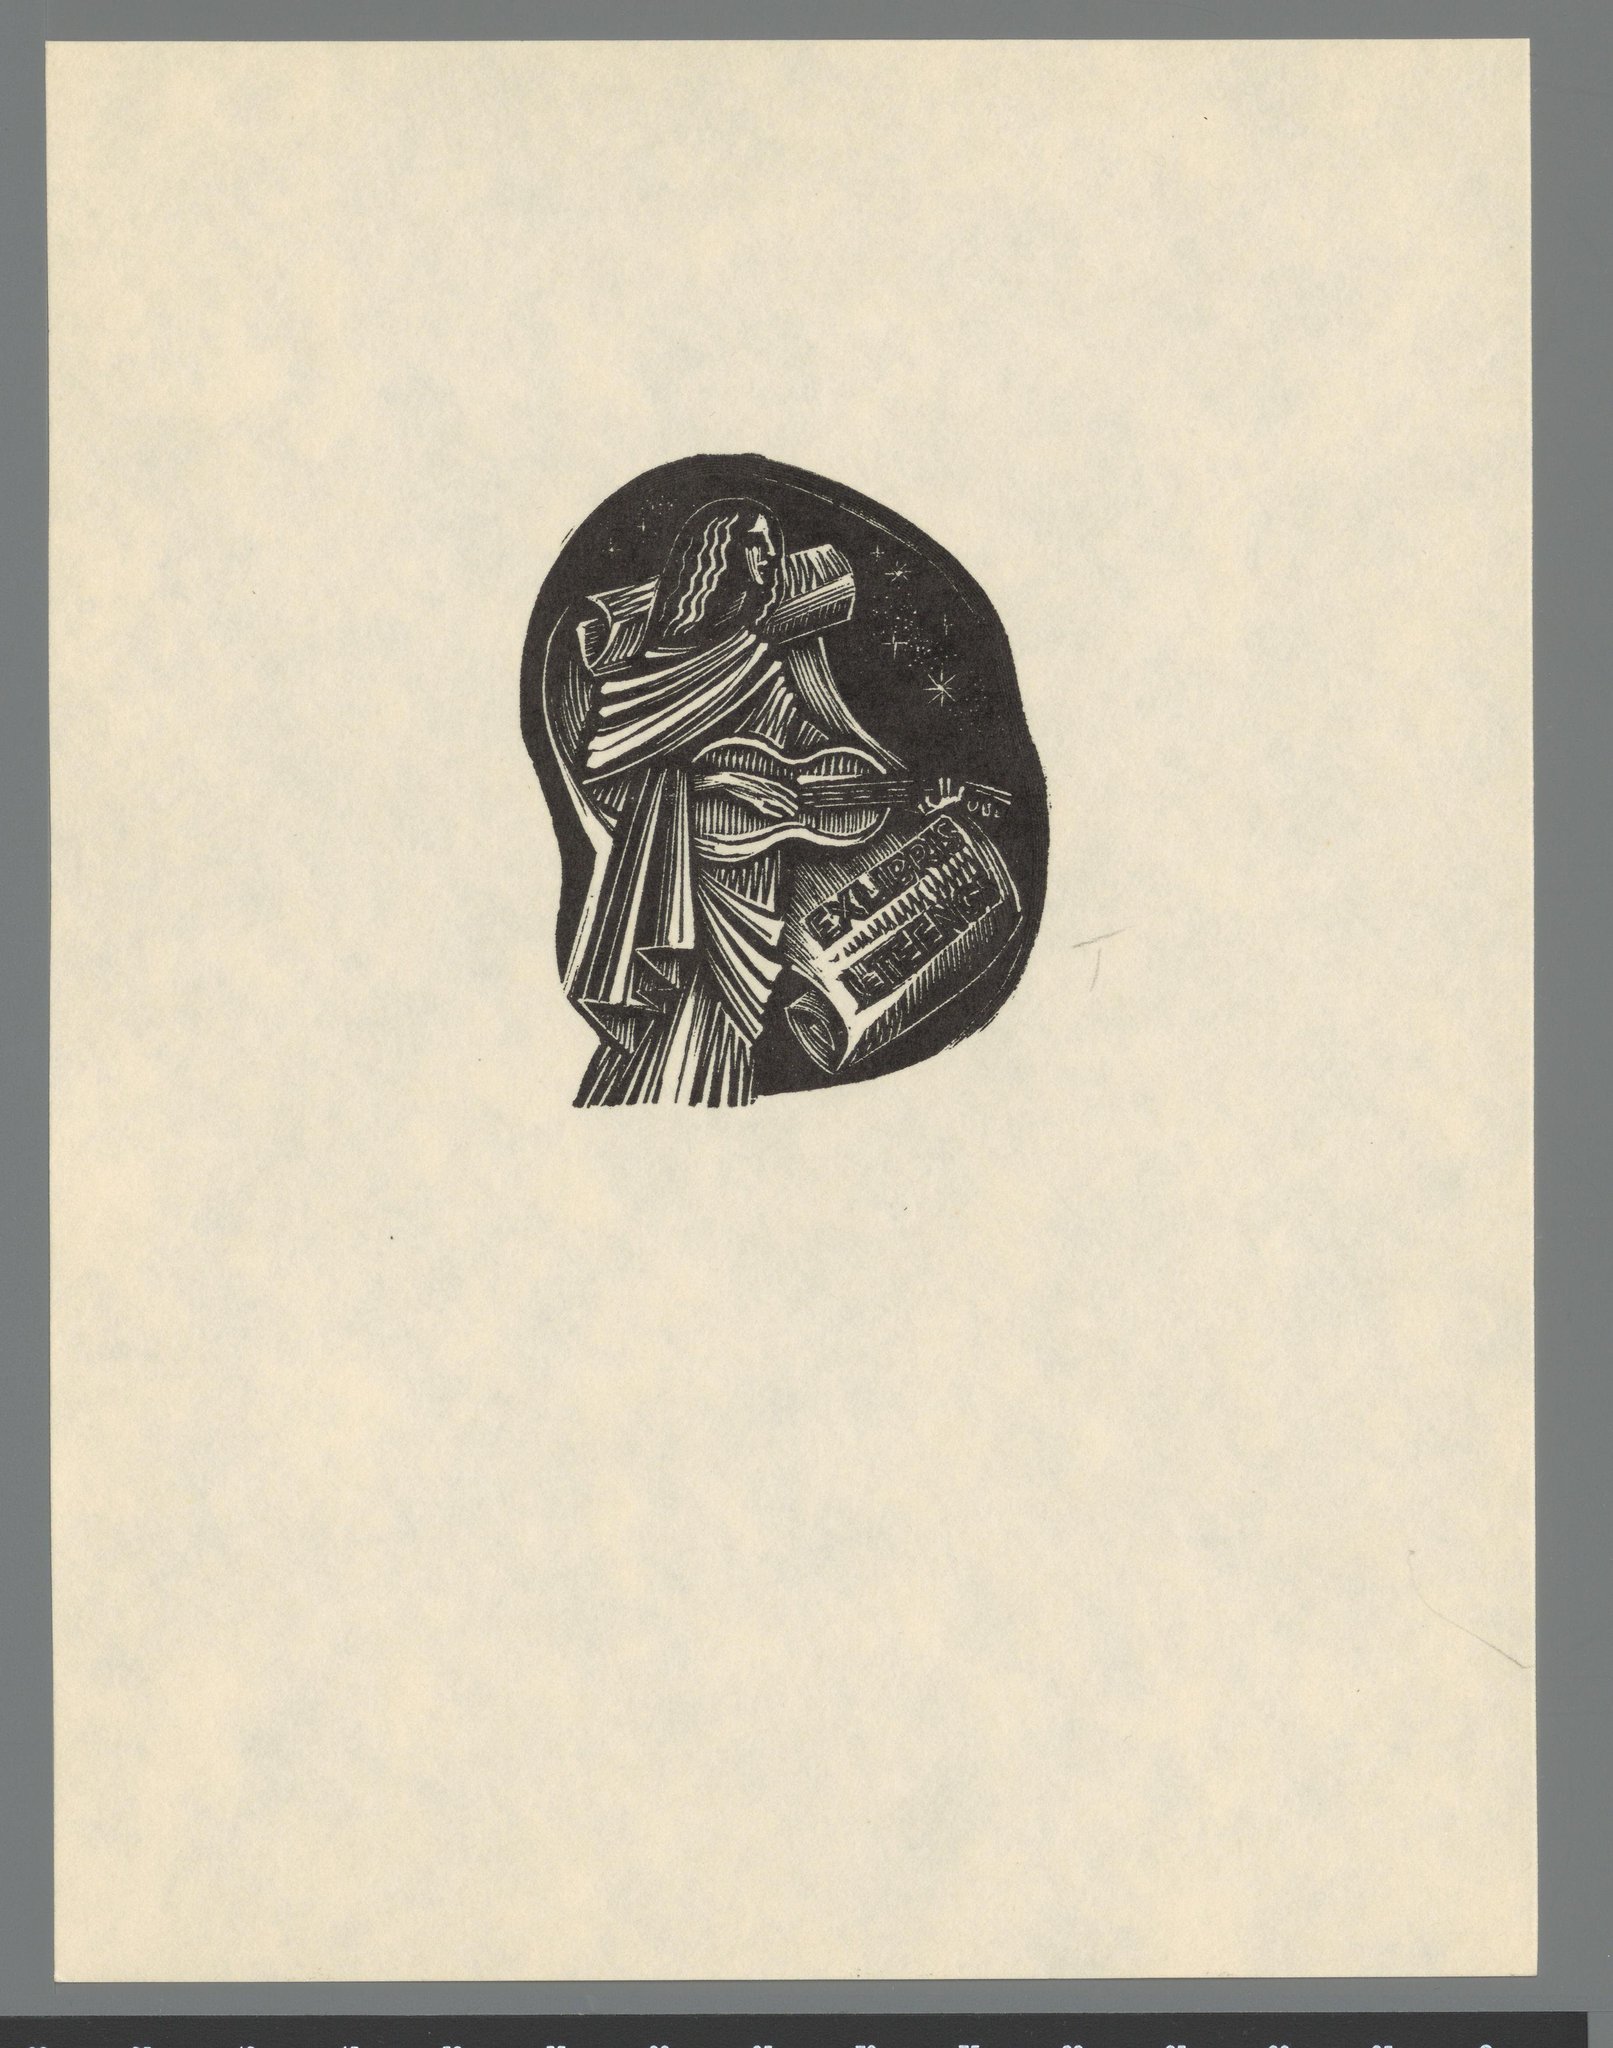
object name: bookplate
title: Ex libris van L. Teengs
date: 1914-1950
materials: paper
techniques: woodcut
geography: poland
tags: standing figure, cithern, mandolin, guitar, balalaika